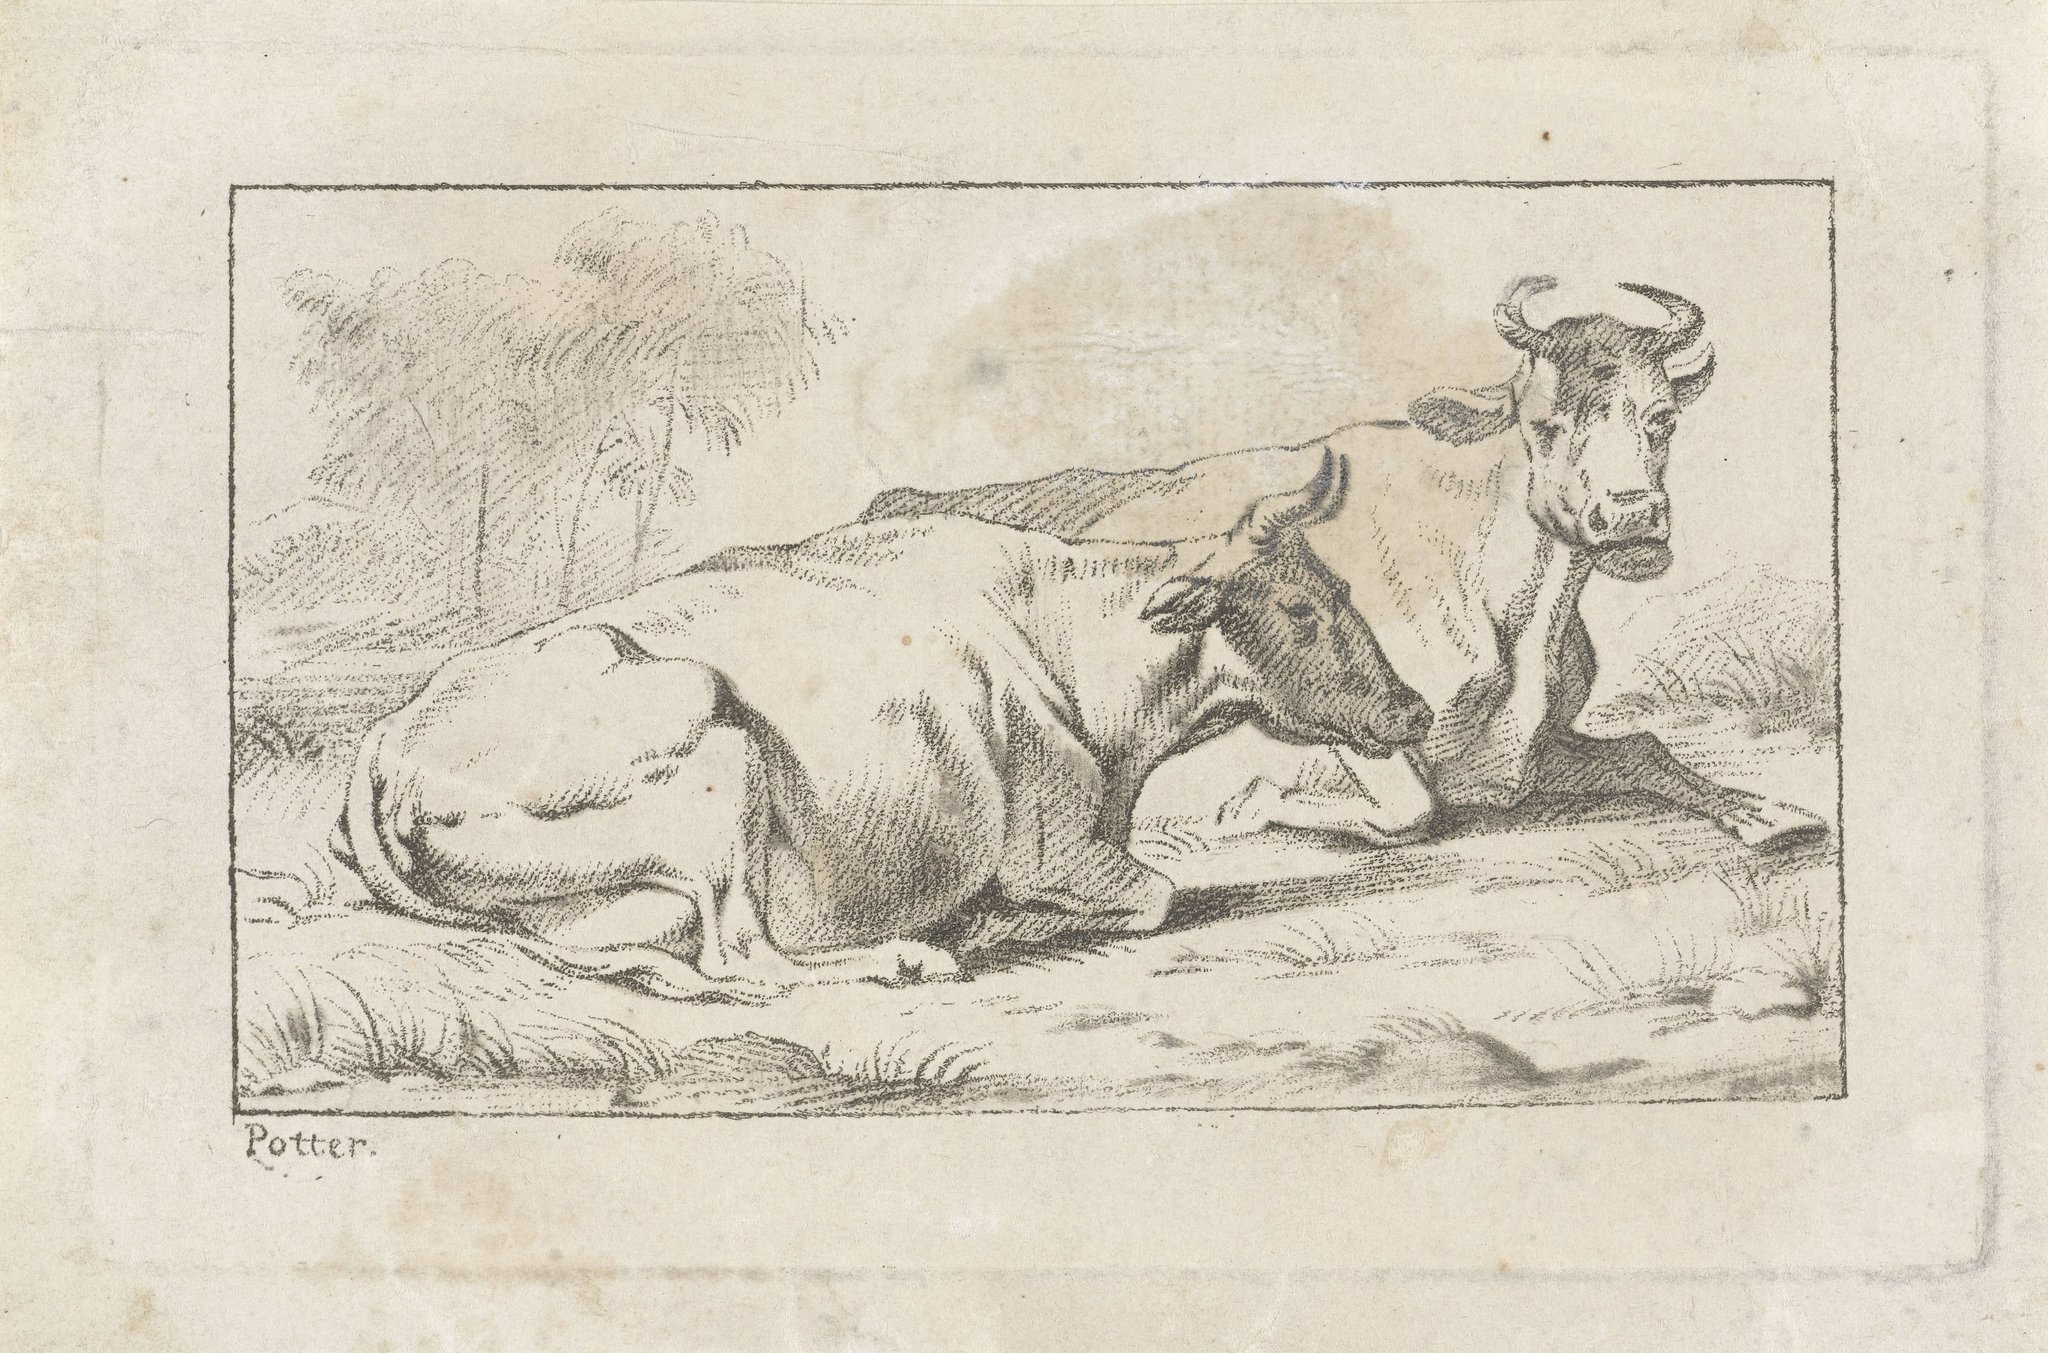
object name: print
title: Twee liggende koeien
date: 1740-1801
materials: paper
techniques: printmaking, etching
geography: amsterdam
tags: cow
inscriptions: collector's mark: Lugt 2228